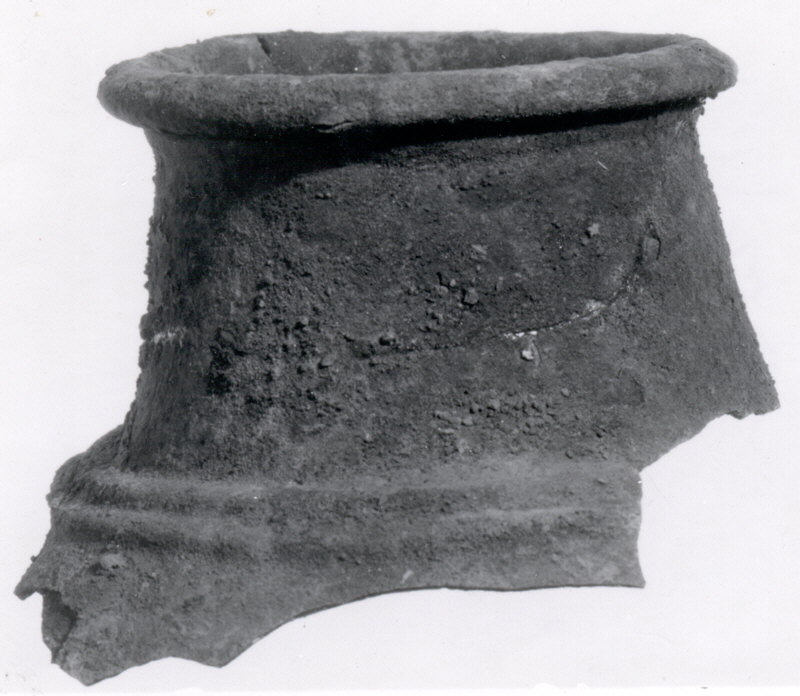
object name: jar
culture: iranian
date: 900-801 BCE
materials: bronze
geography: iran